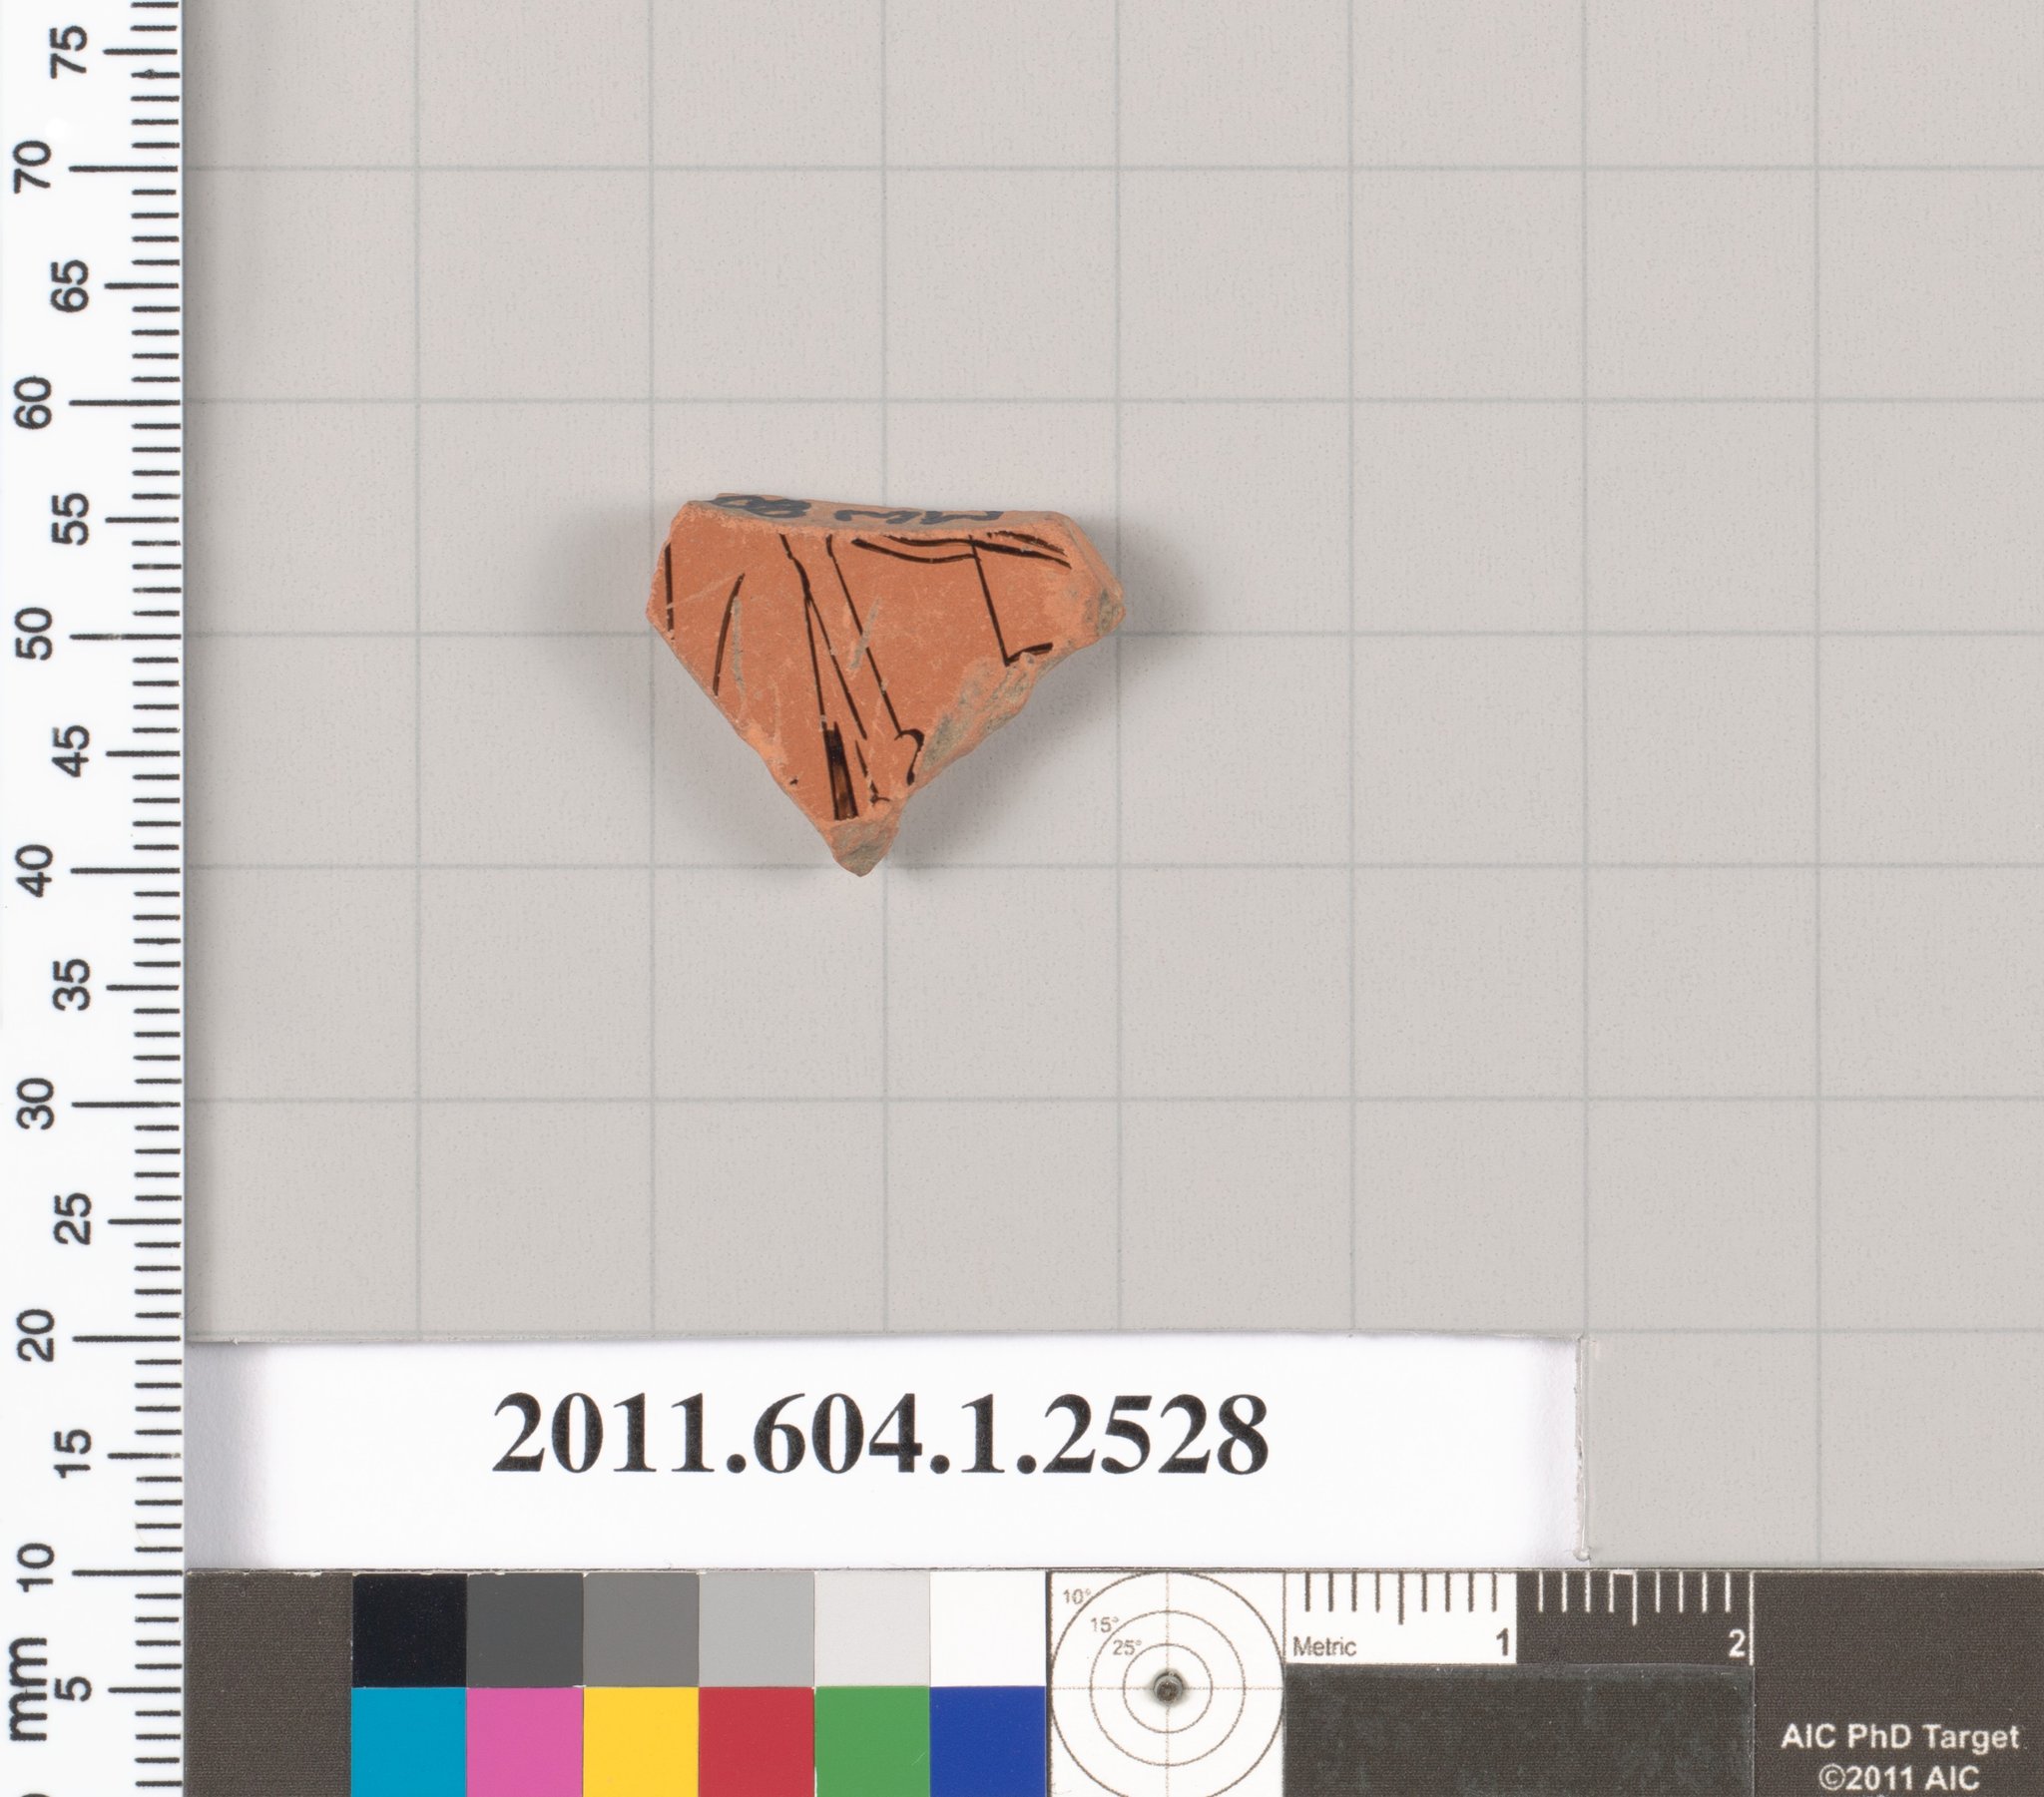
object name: kylix fragment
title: Terracotta fragment of a kylix (drinking cup)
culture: greek, attic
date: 475-451 BCE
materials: terracotta